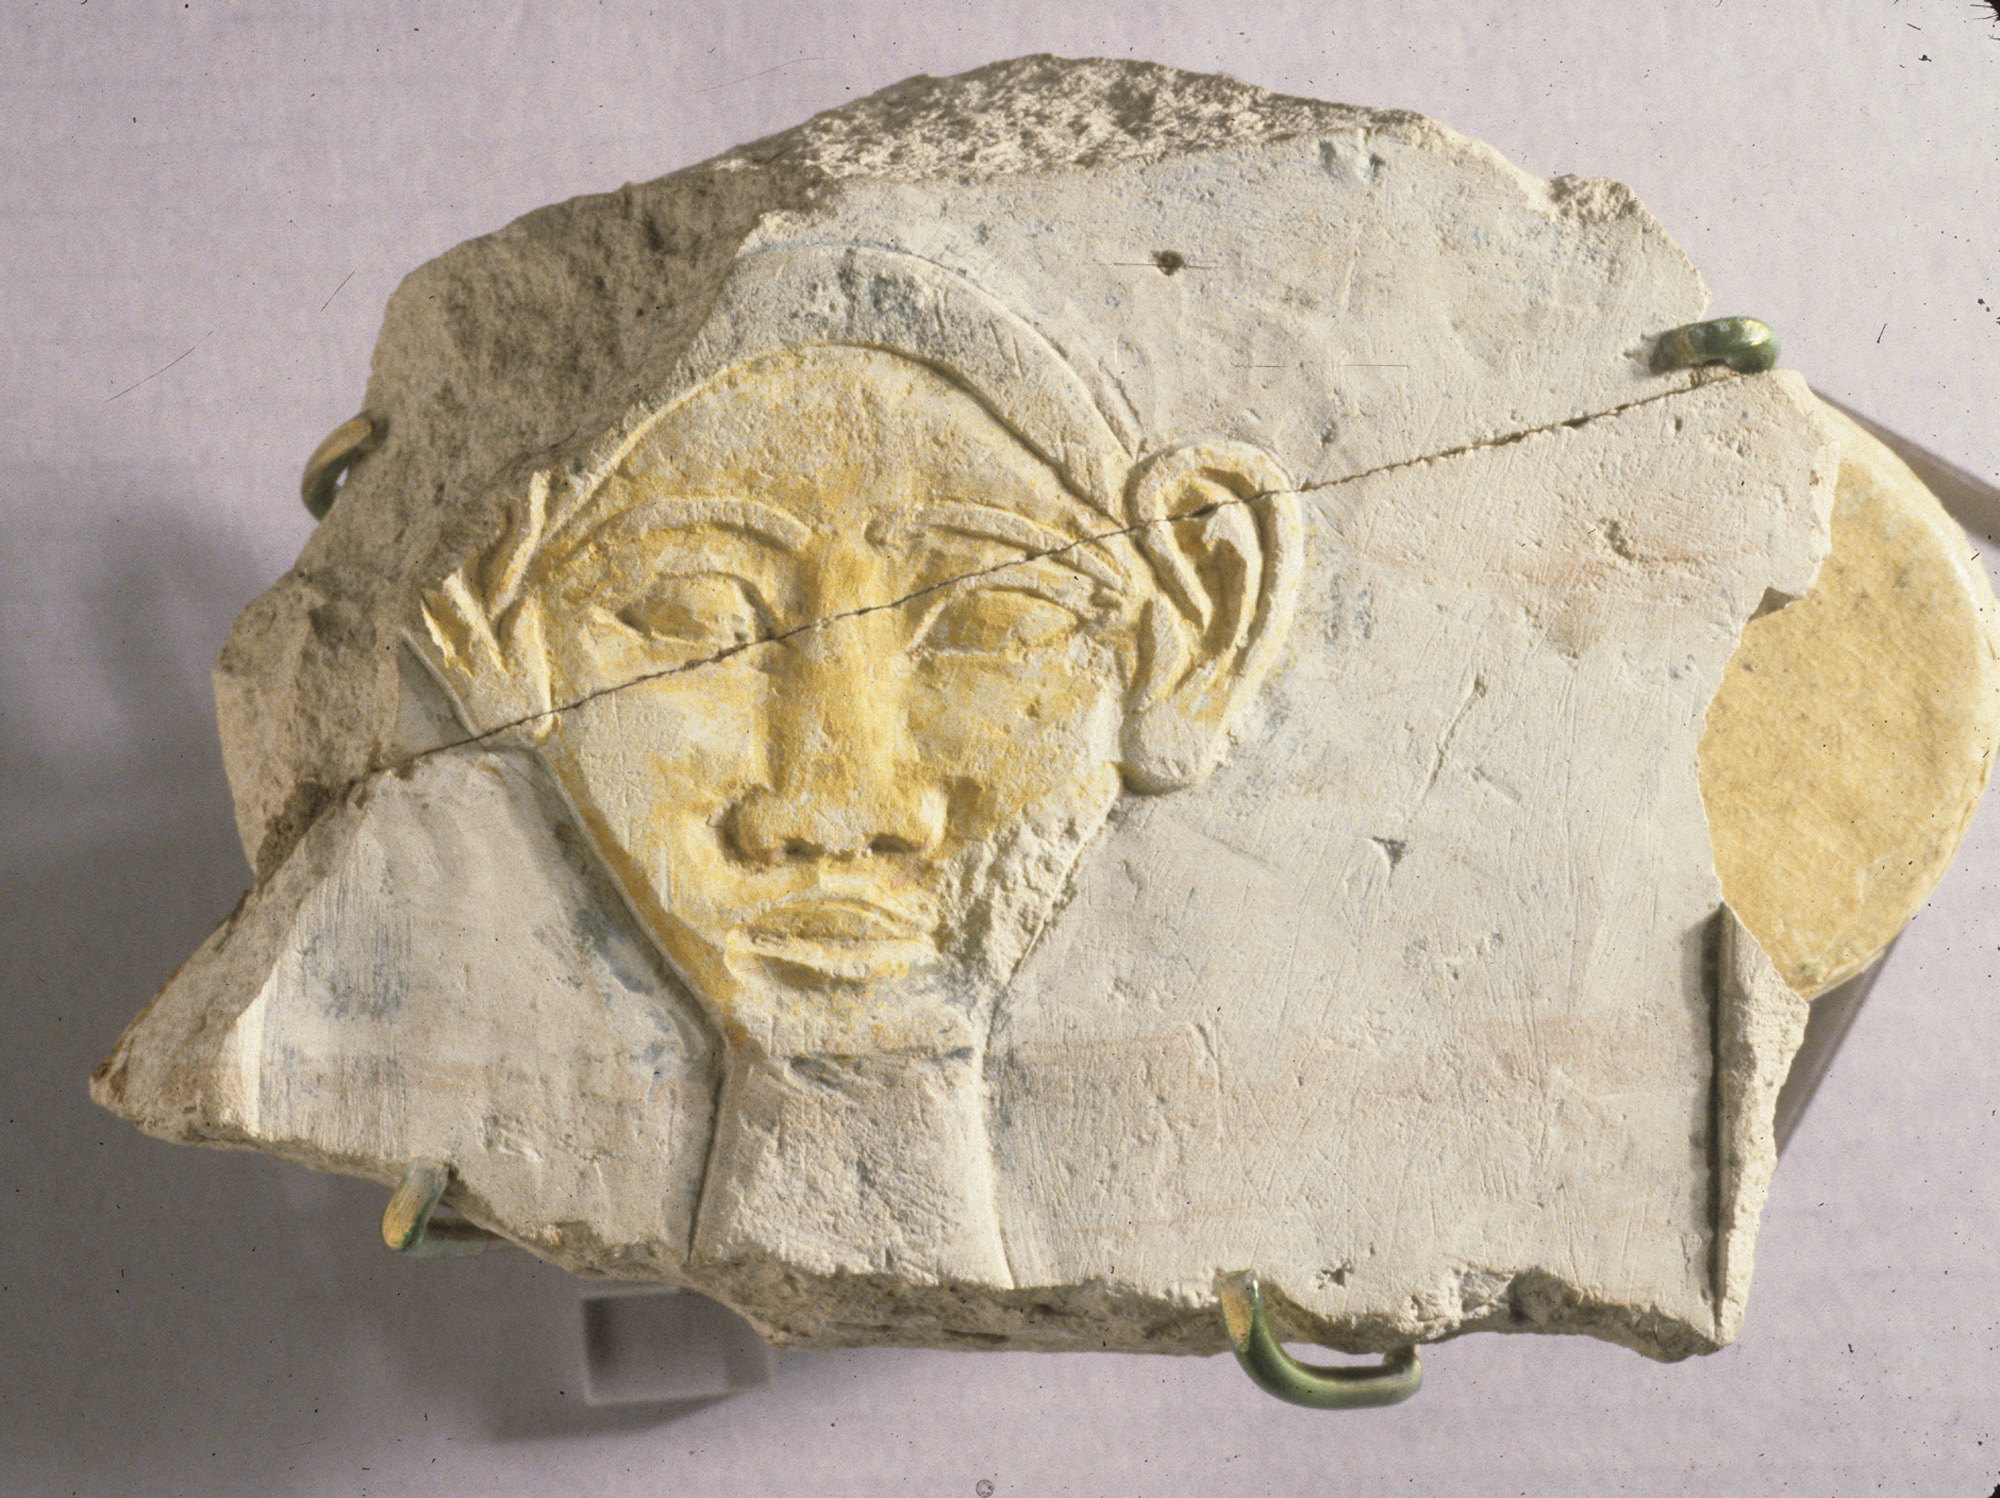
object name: relief, hr hieroglyph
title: Relief Fragment , "hr" hieroglyph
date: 1479-1458 BCE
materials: limestone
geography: upper egypt, thebes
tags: faces